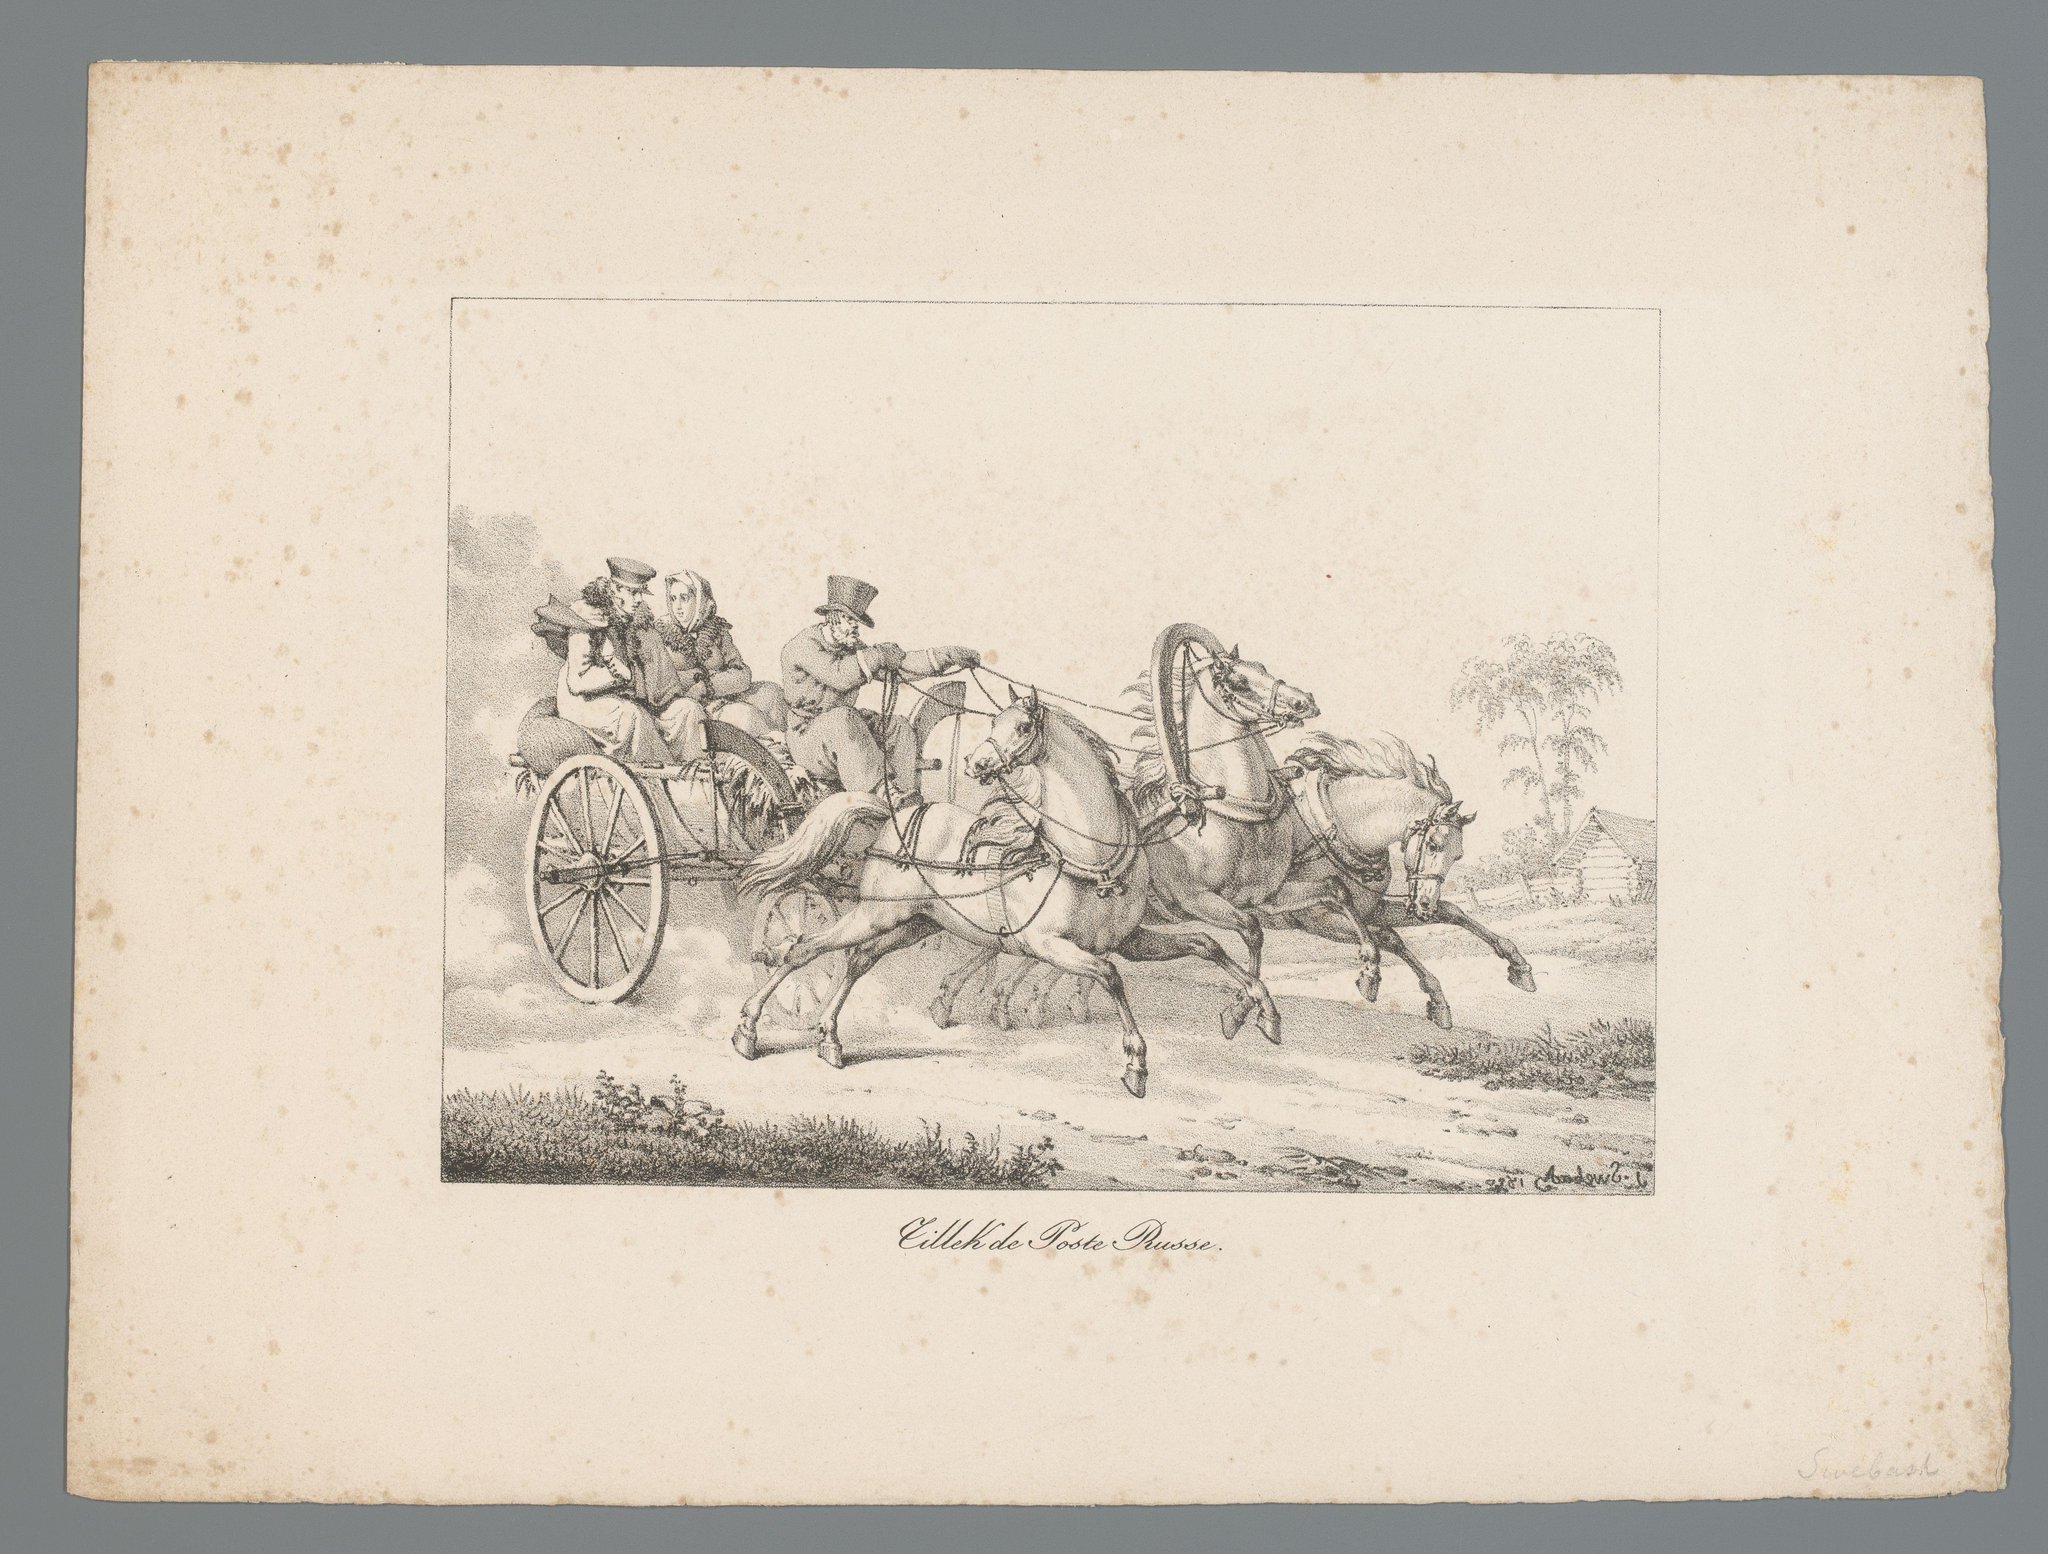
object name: print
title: Koets met drie paarden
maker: jacques françois joseph swebach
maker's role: print maker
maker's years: 1769-1823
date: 1822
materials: paper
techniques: lithograph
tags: postal service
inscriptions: collector's mark: Lugt 2228